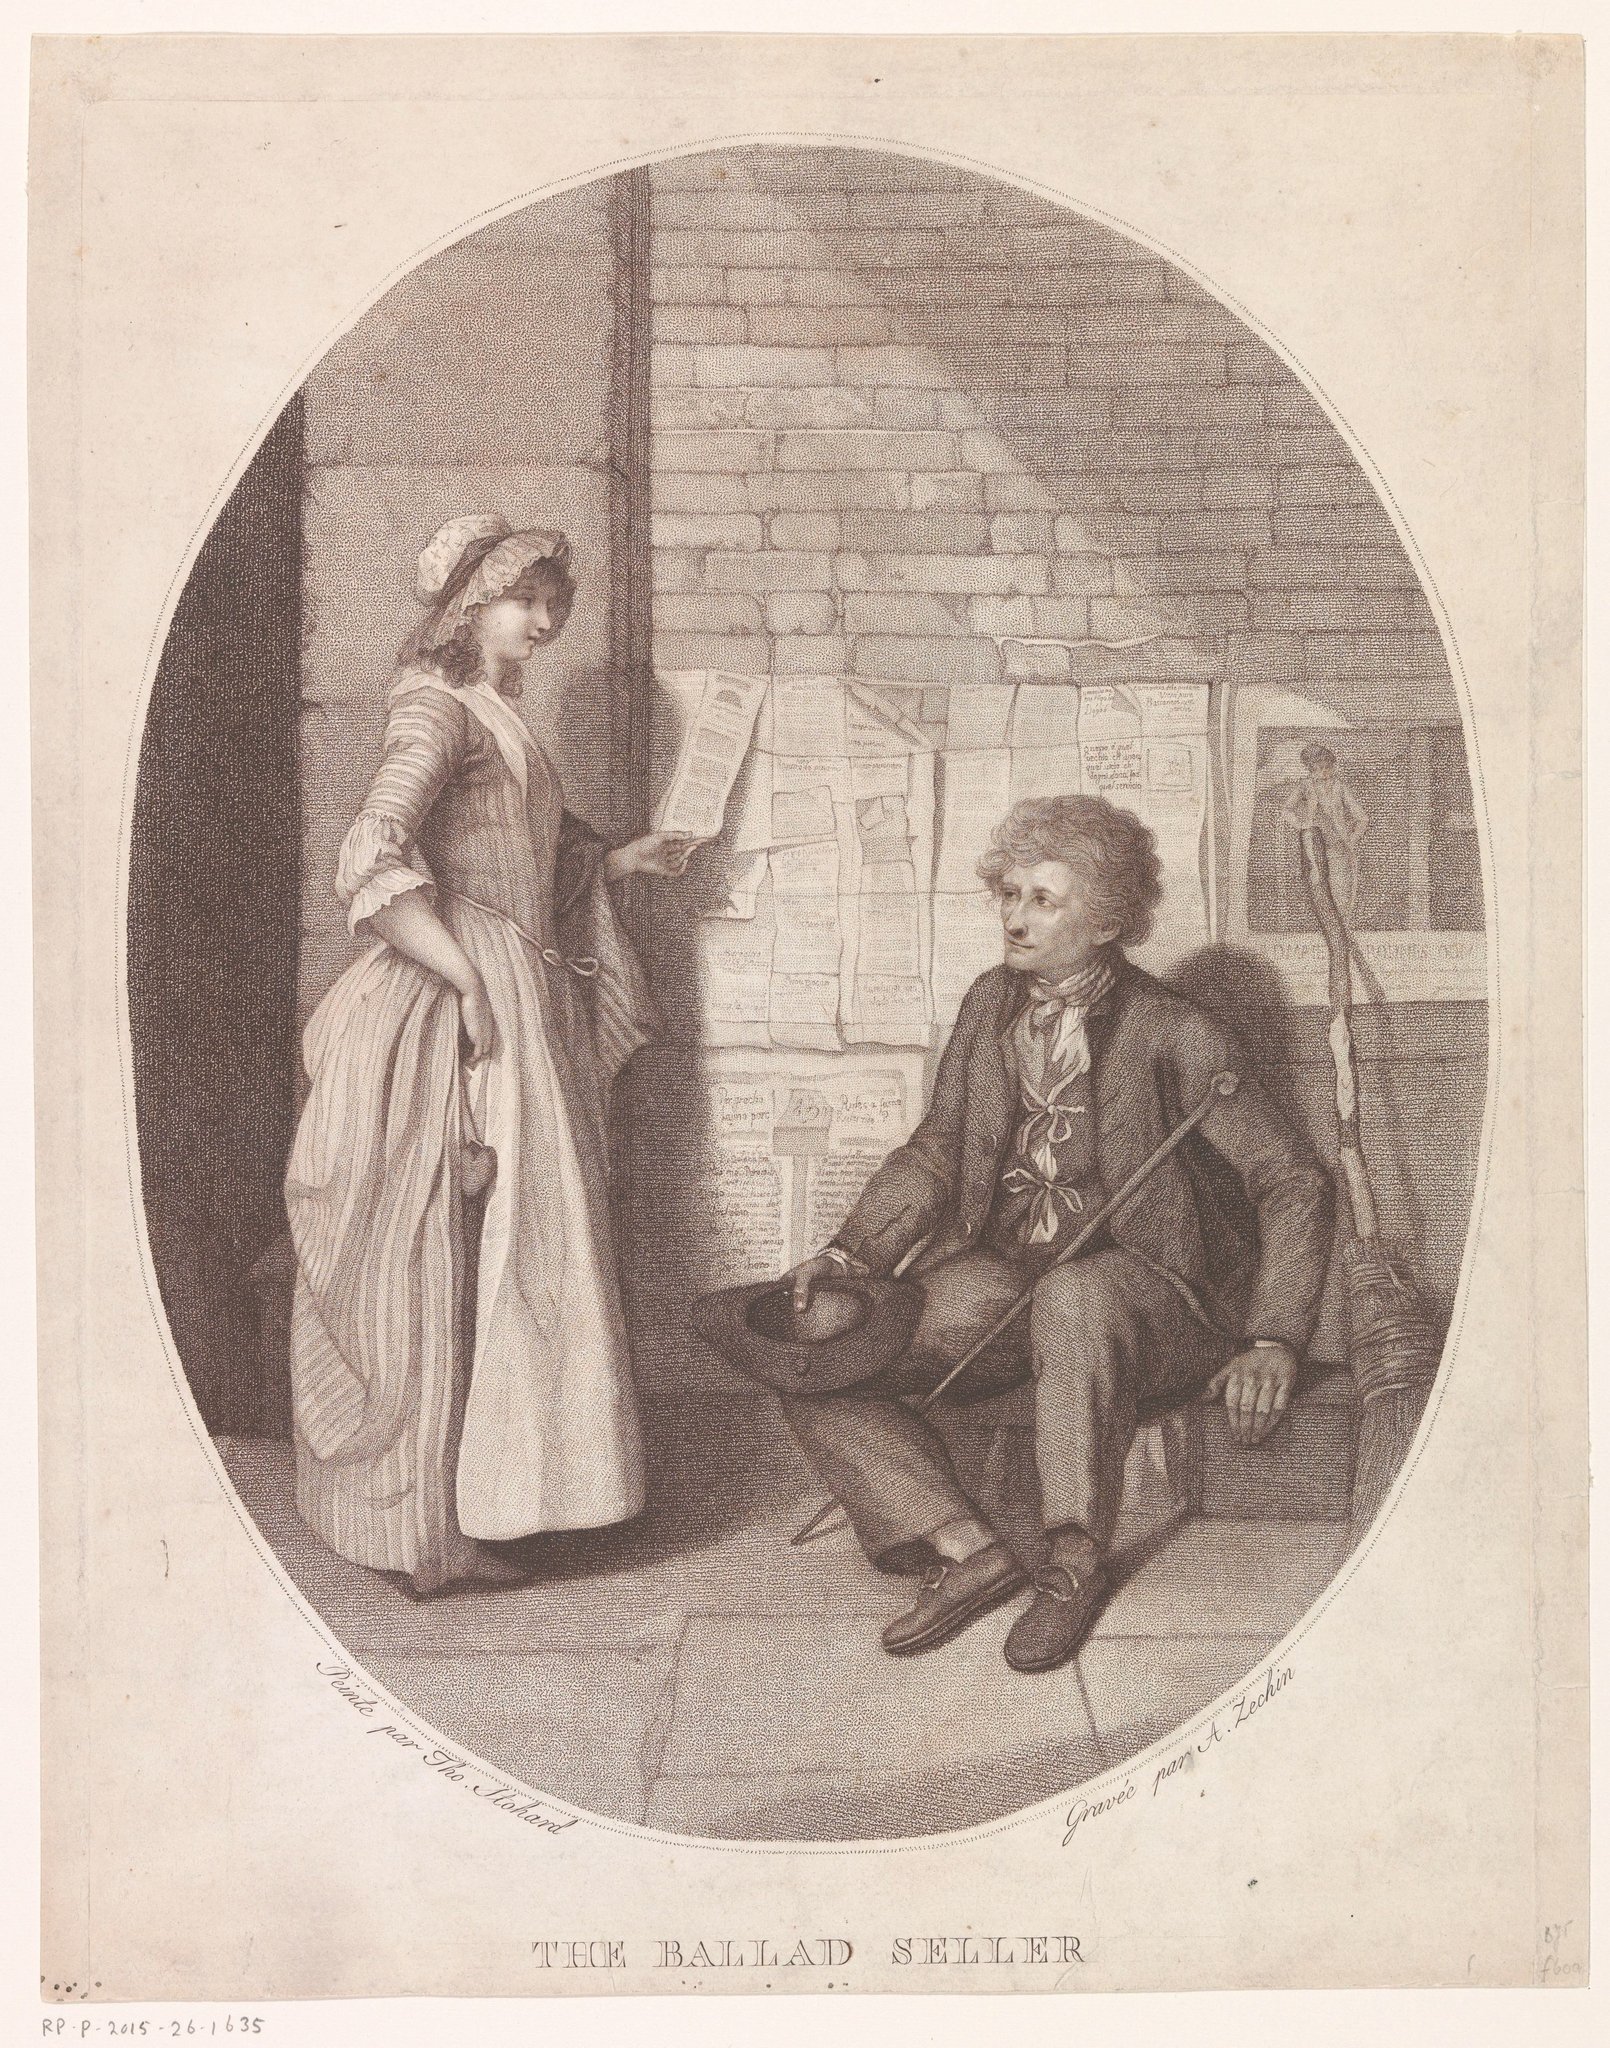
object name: print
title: Jonge vrouw en een liedverkoper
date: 1795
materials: paper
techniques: etching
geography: venice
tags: street-trader, beggar, ballad singer, ballad seller - cc - out of doors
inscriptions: collector's mark: Lugt 2228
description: Op straat zit een liedverkoper met zijn hoed in zijn handen en een wandelstok tegen zijn been geleund. Achter hem hangt zijn voorraad liederen aan de muur. Een jonge vrouw bekijkt een van de liederen. Naast de liedverkoper leunt een bezem tegen een prent met een portret.